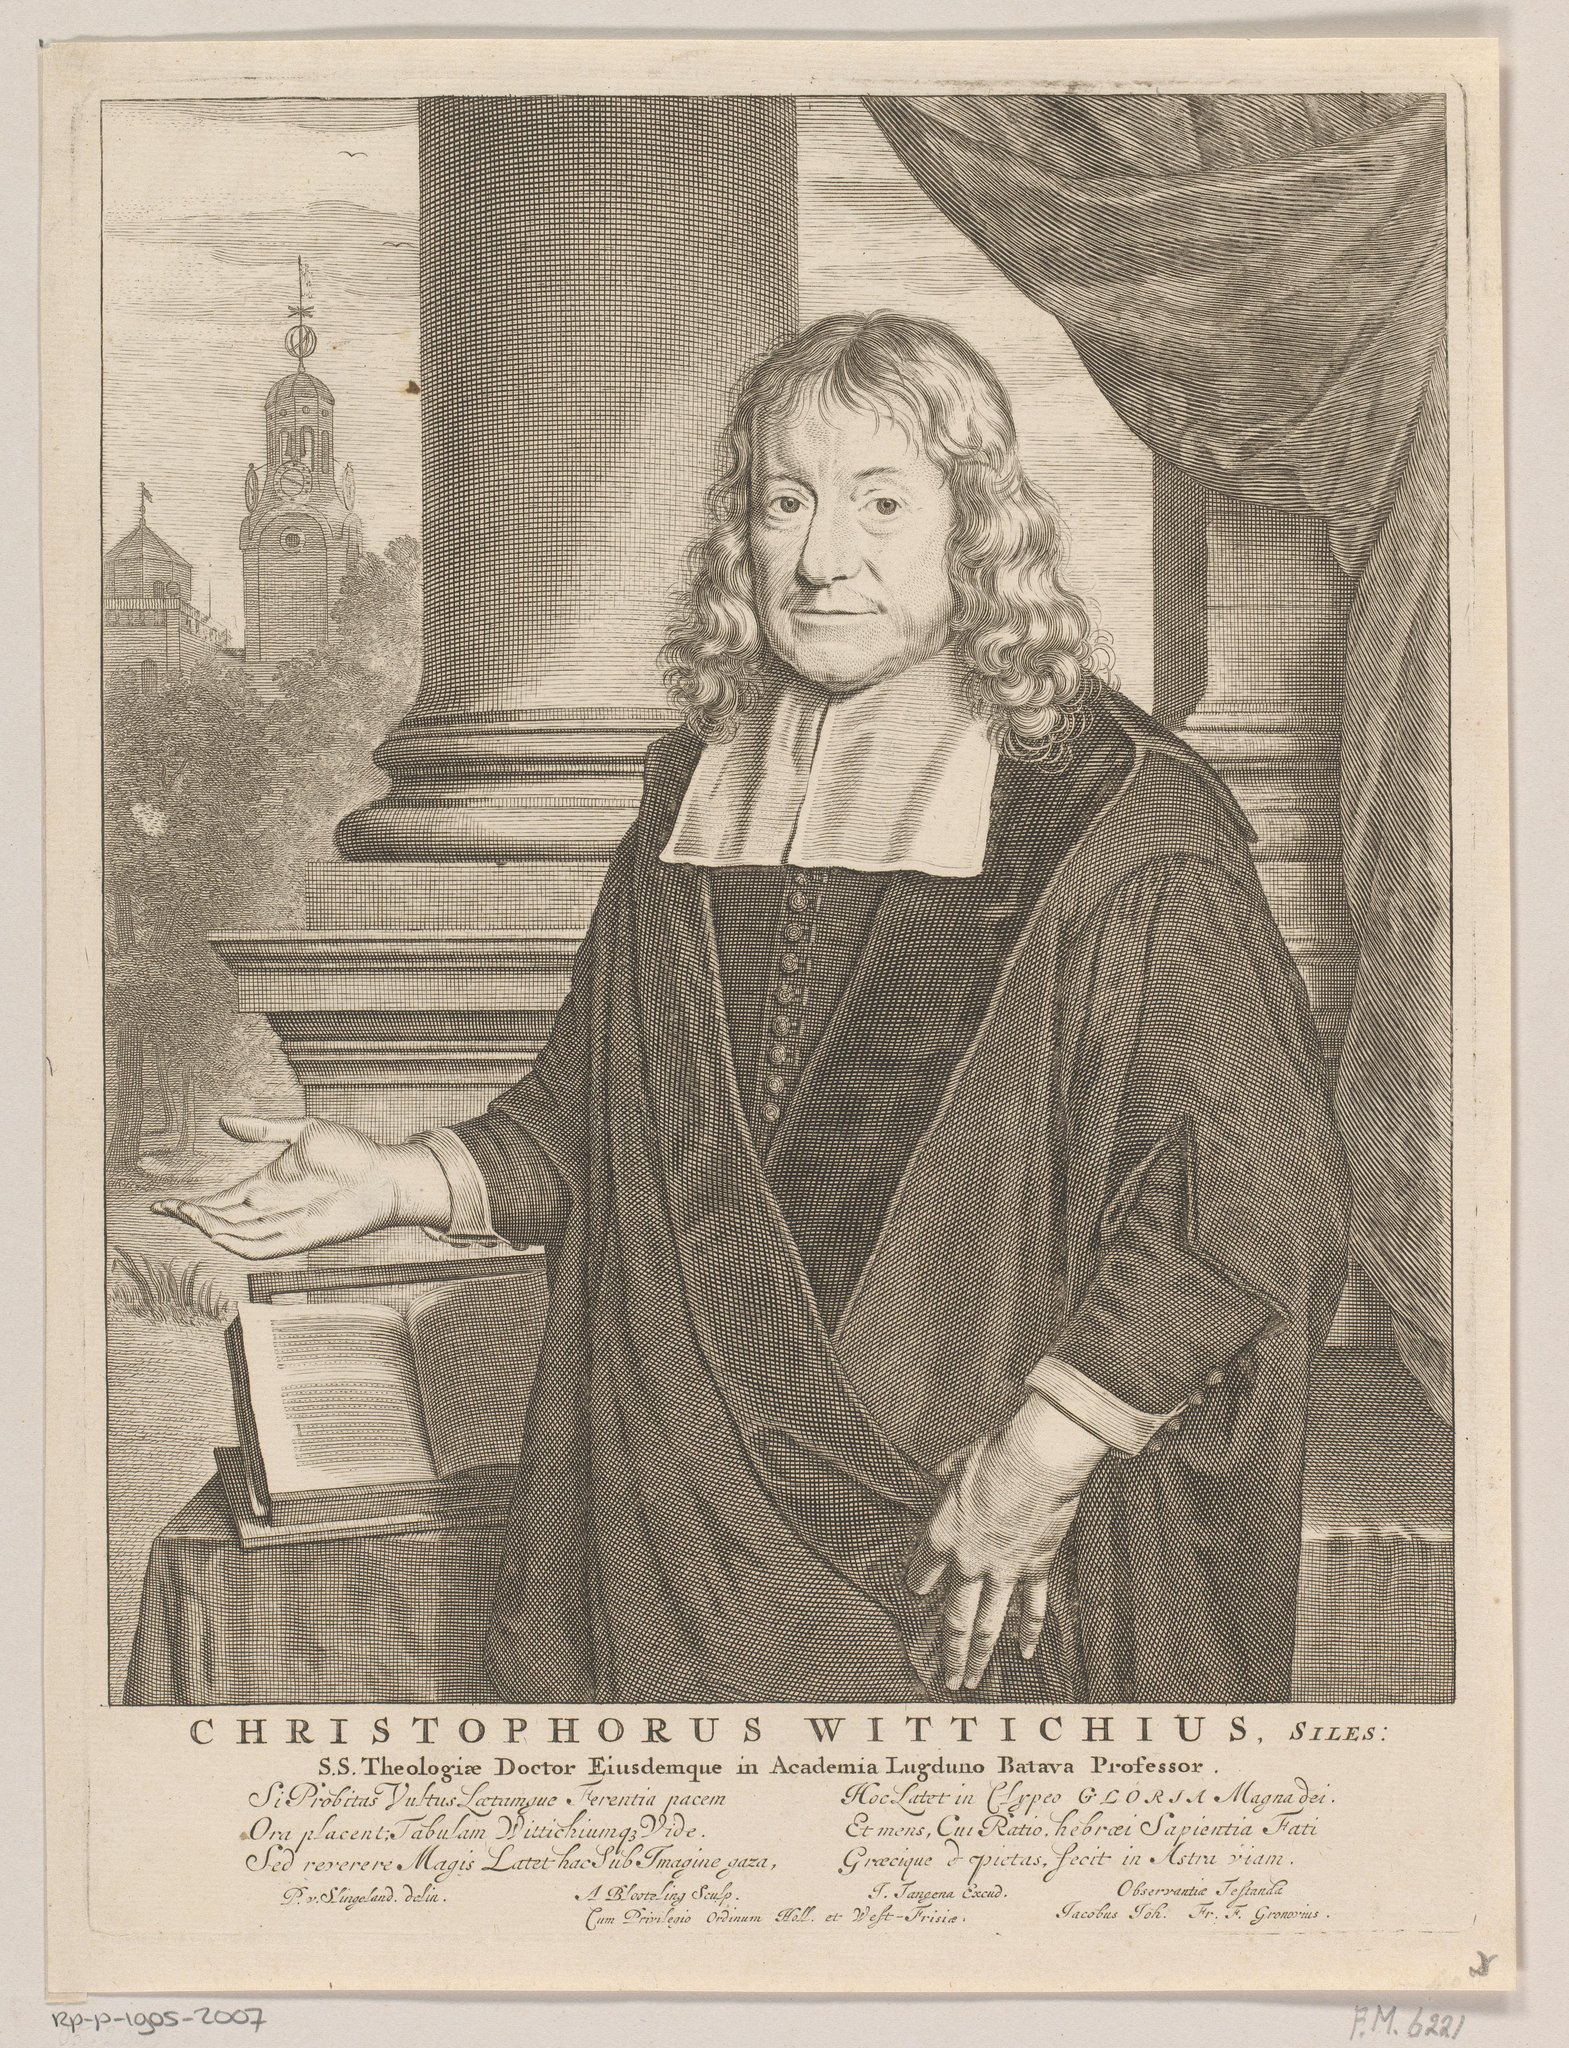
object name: print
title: Portret van Christophorus Wittichius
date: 1671-1690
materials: paper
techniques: engraving, etching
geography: leiden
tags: poland, leiden, theologian, historical persons, professor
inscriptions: collector's mark: Lugt 2228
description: Met zevenregelig onderschrift in het Latijn in twee kolommen.